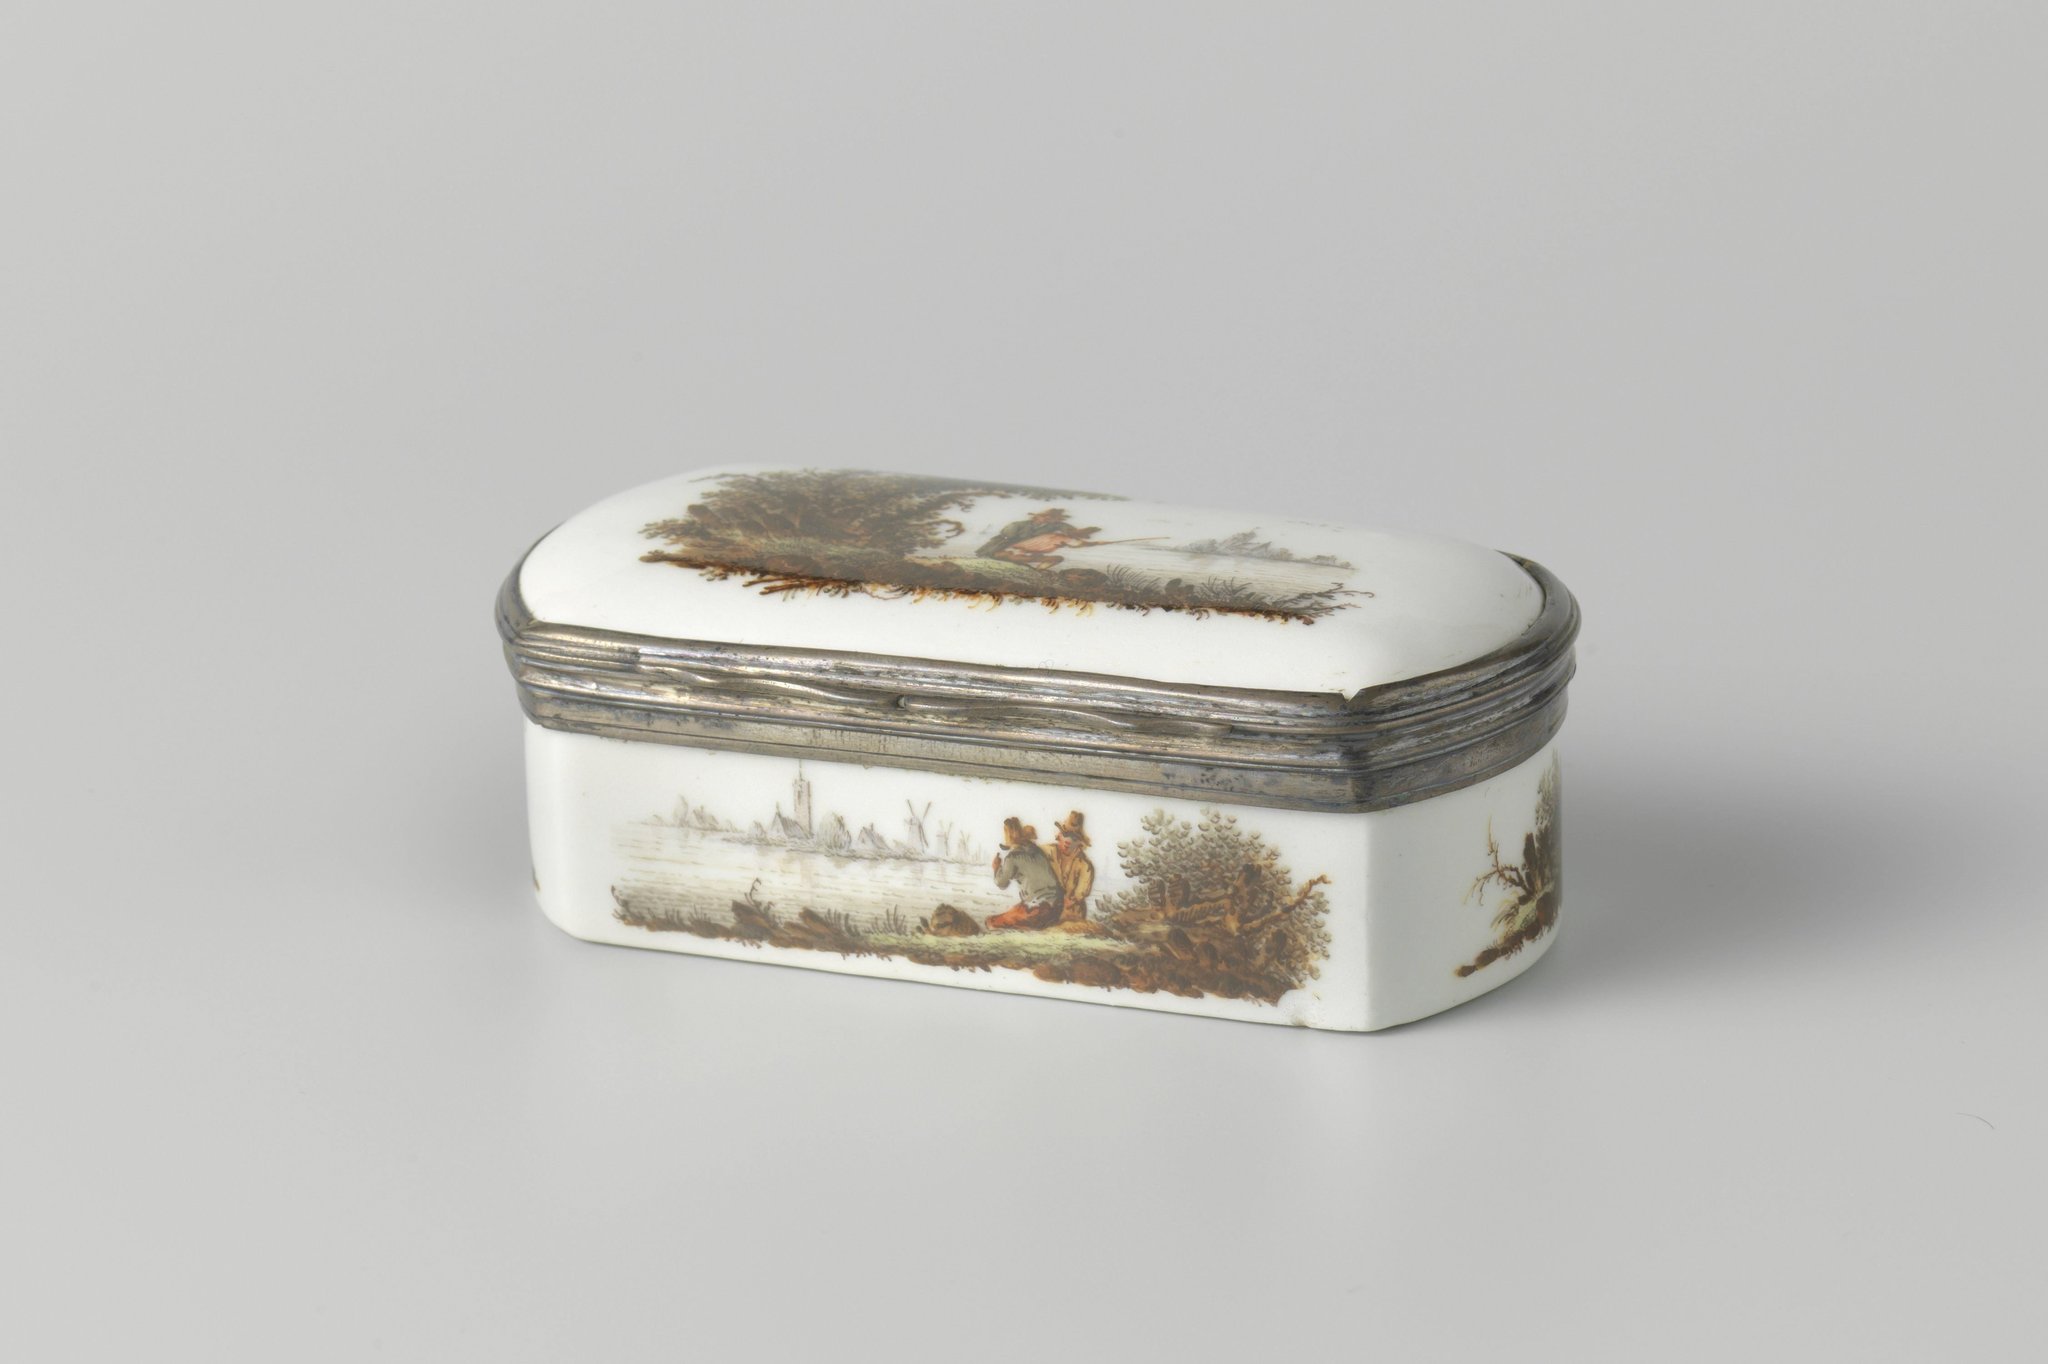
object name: box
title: Snuifdoos beschilderd met waterlandschappen en figuren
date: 1774-1784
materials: porcelain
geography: loosdrecht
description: Snuff box. Porcelain with silver mount. Loosdrecht, c. 1778 - 1782. Factory of Joannes de Mol.